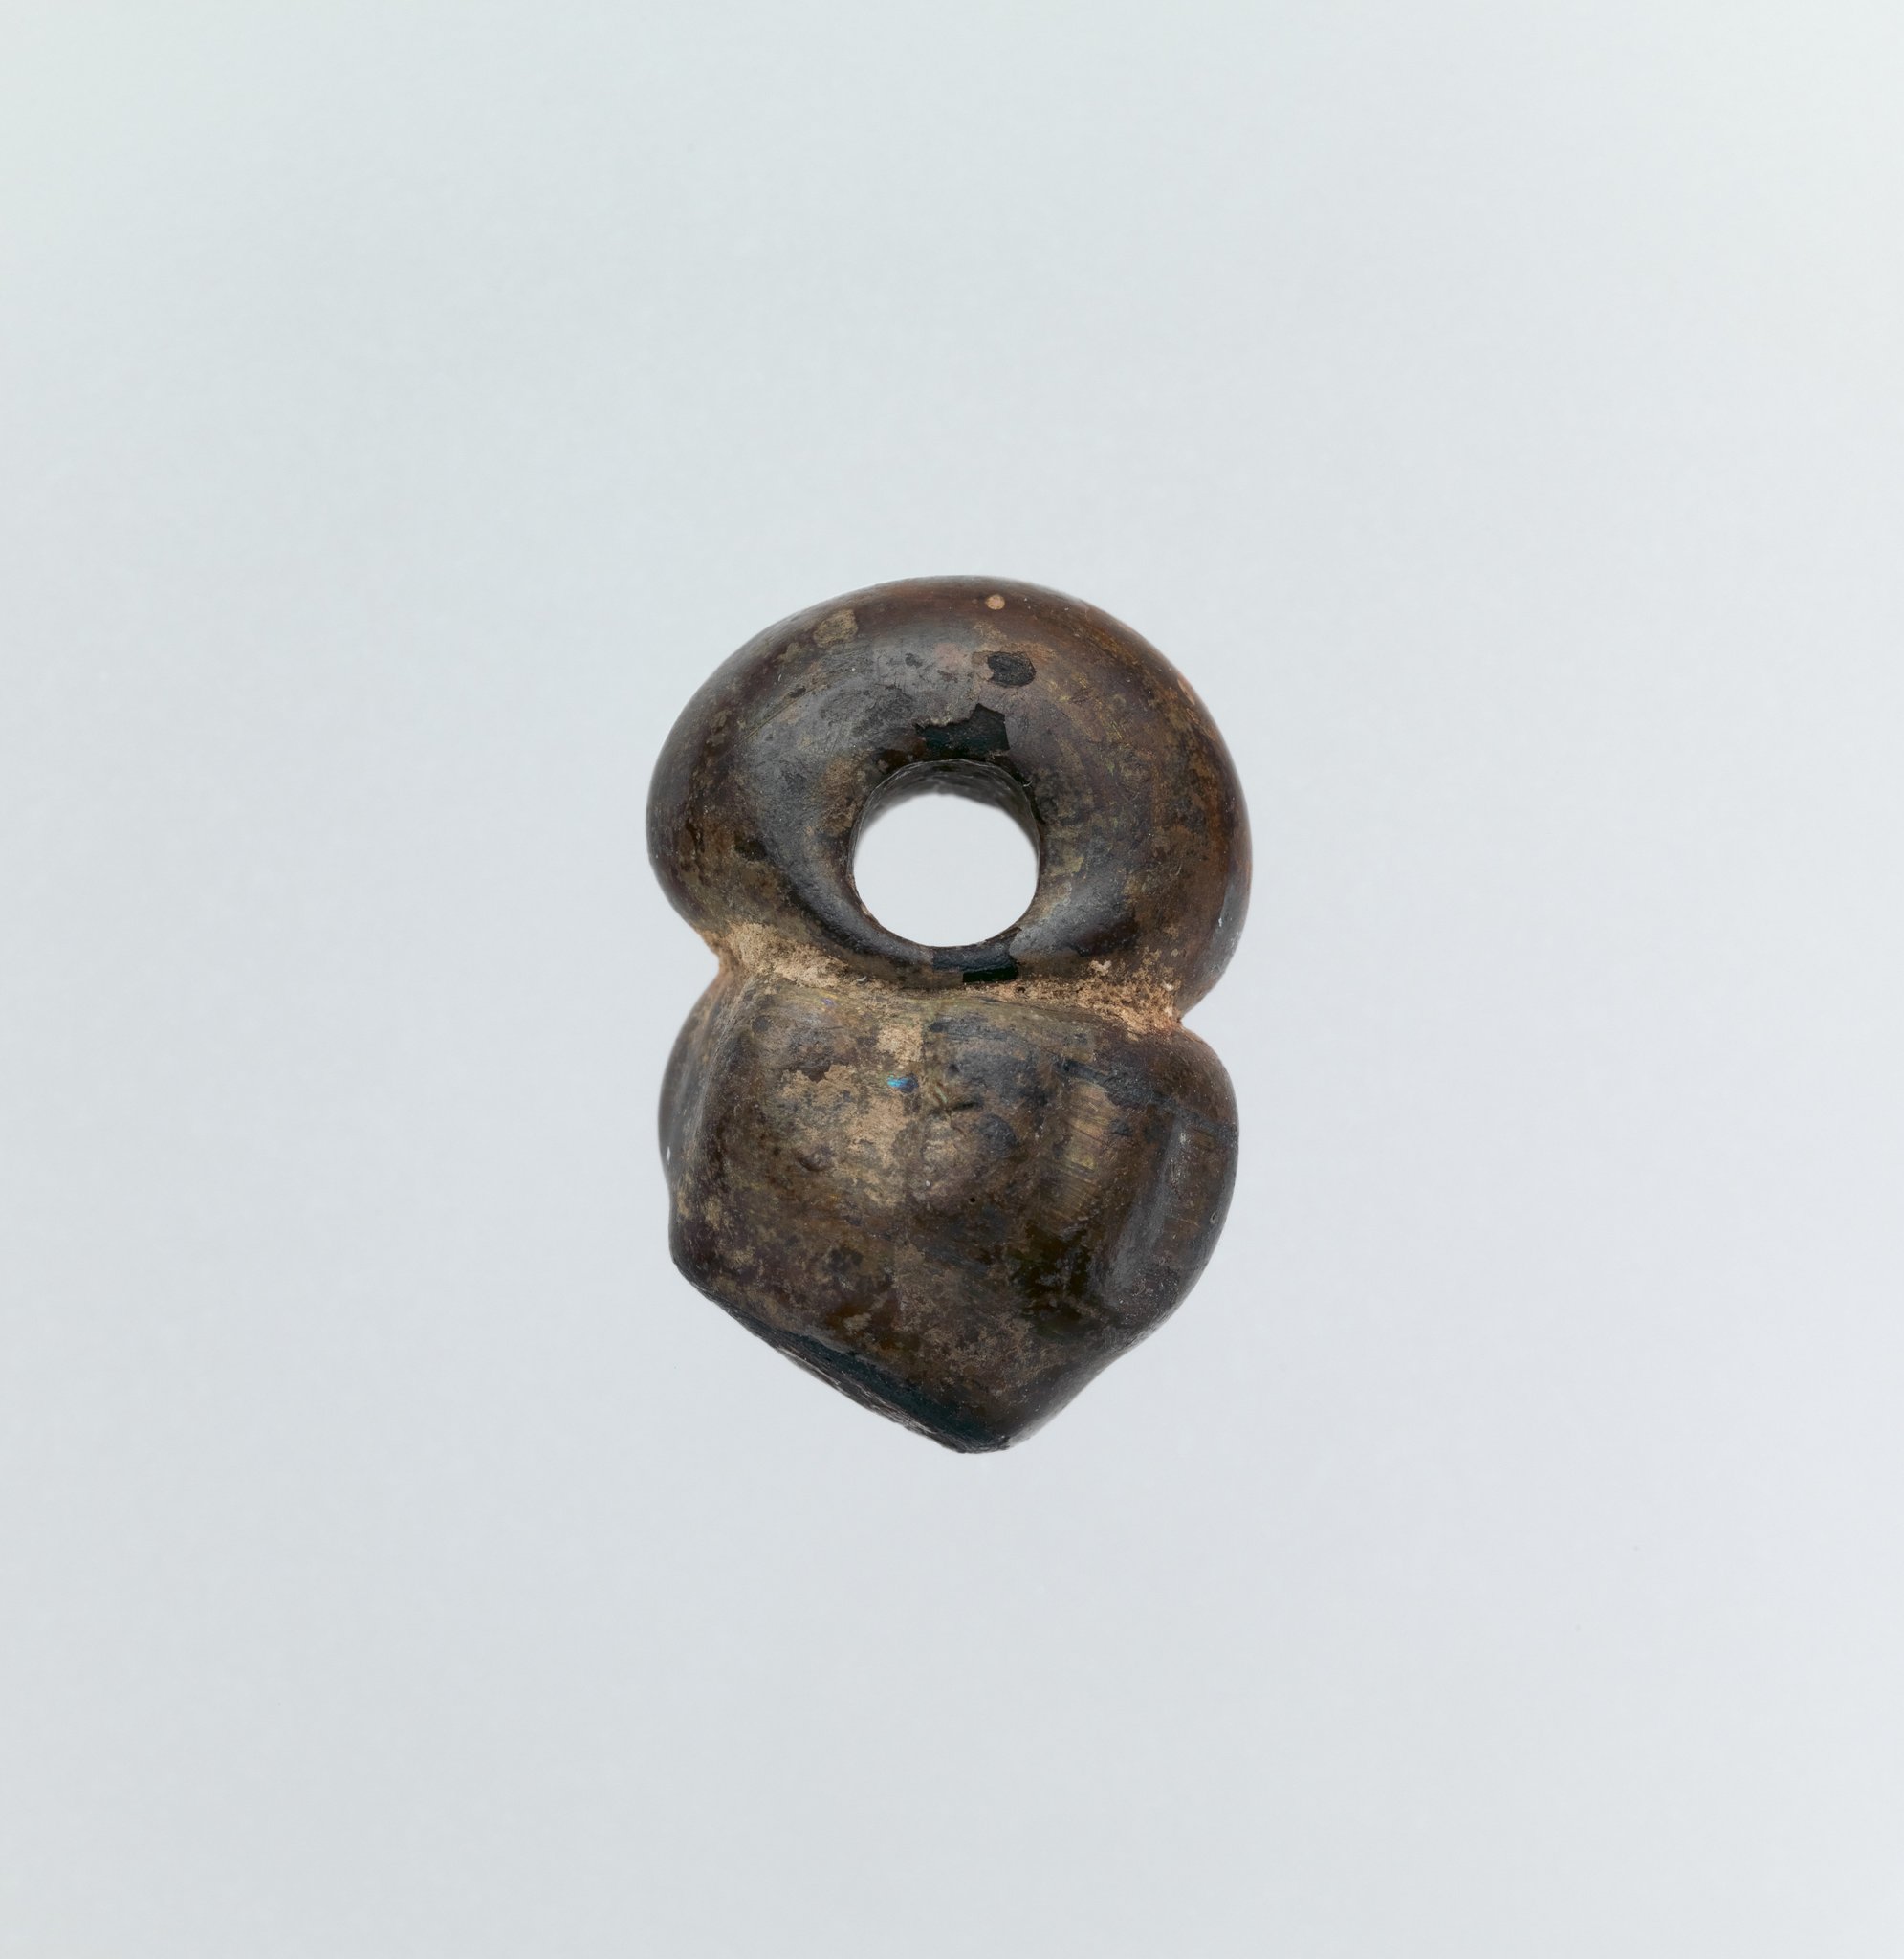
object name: pendant in the form of a jar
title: Glass pendant in the form of a miniature jar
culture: roman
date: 267-400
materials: glass